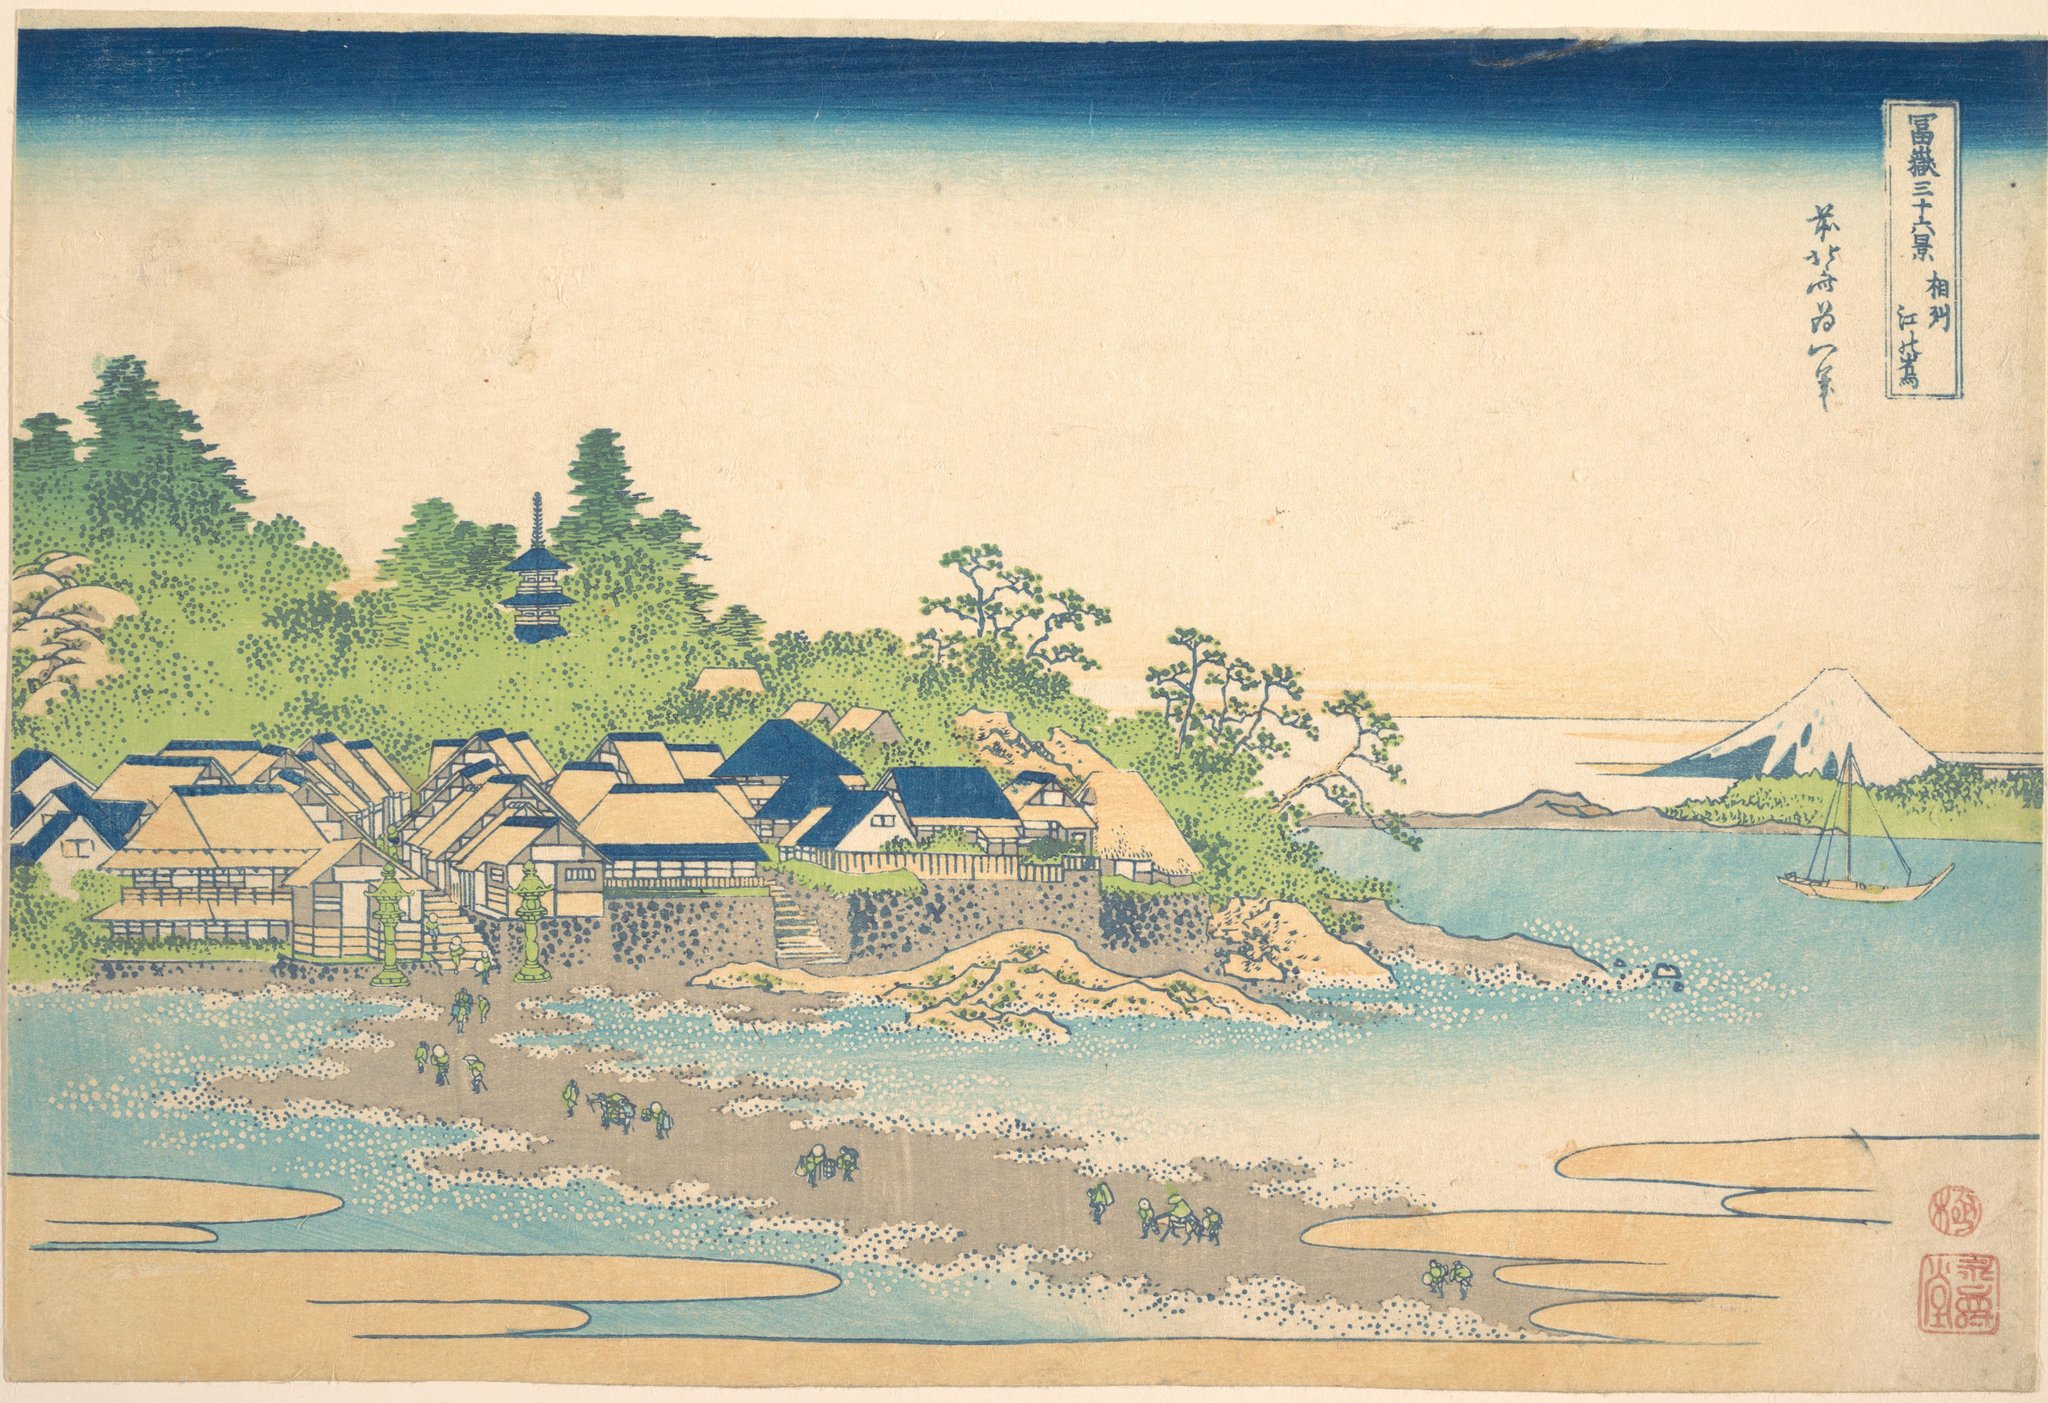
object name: woodblock print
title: Enoshima in Sagami Province (Sōshū Enoshima), from the series Thirty-six Views of Mount Fuji (Fugaku sanjūrokkei)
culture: japanese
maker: katsushika hokusai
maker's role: artist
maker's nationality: japanese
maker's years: 1760-1849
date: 1830-1832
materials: ink, paper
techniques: woodblock print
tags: buildings,mountains,landscapes,boats